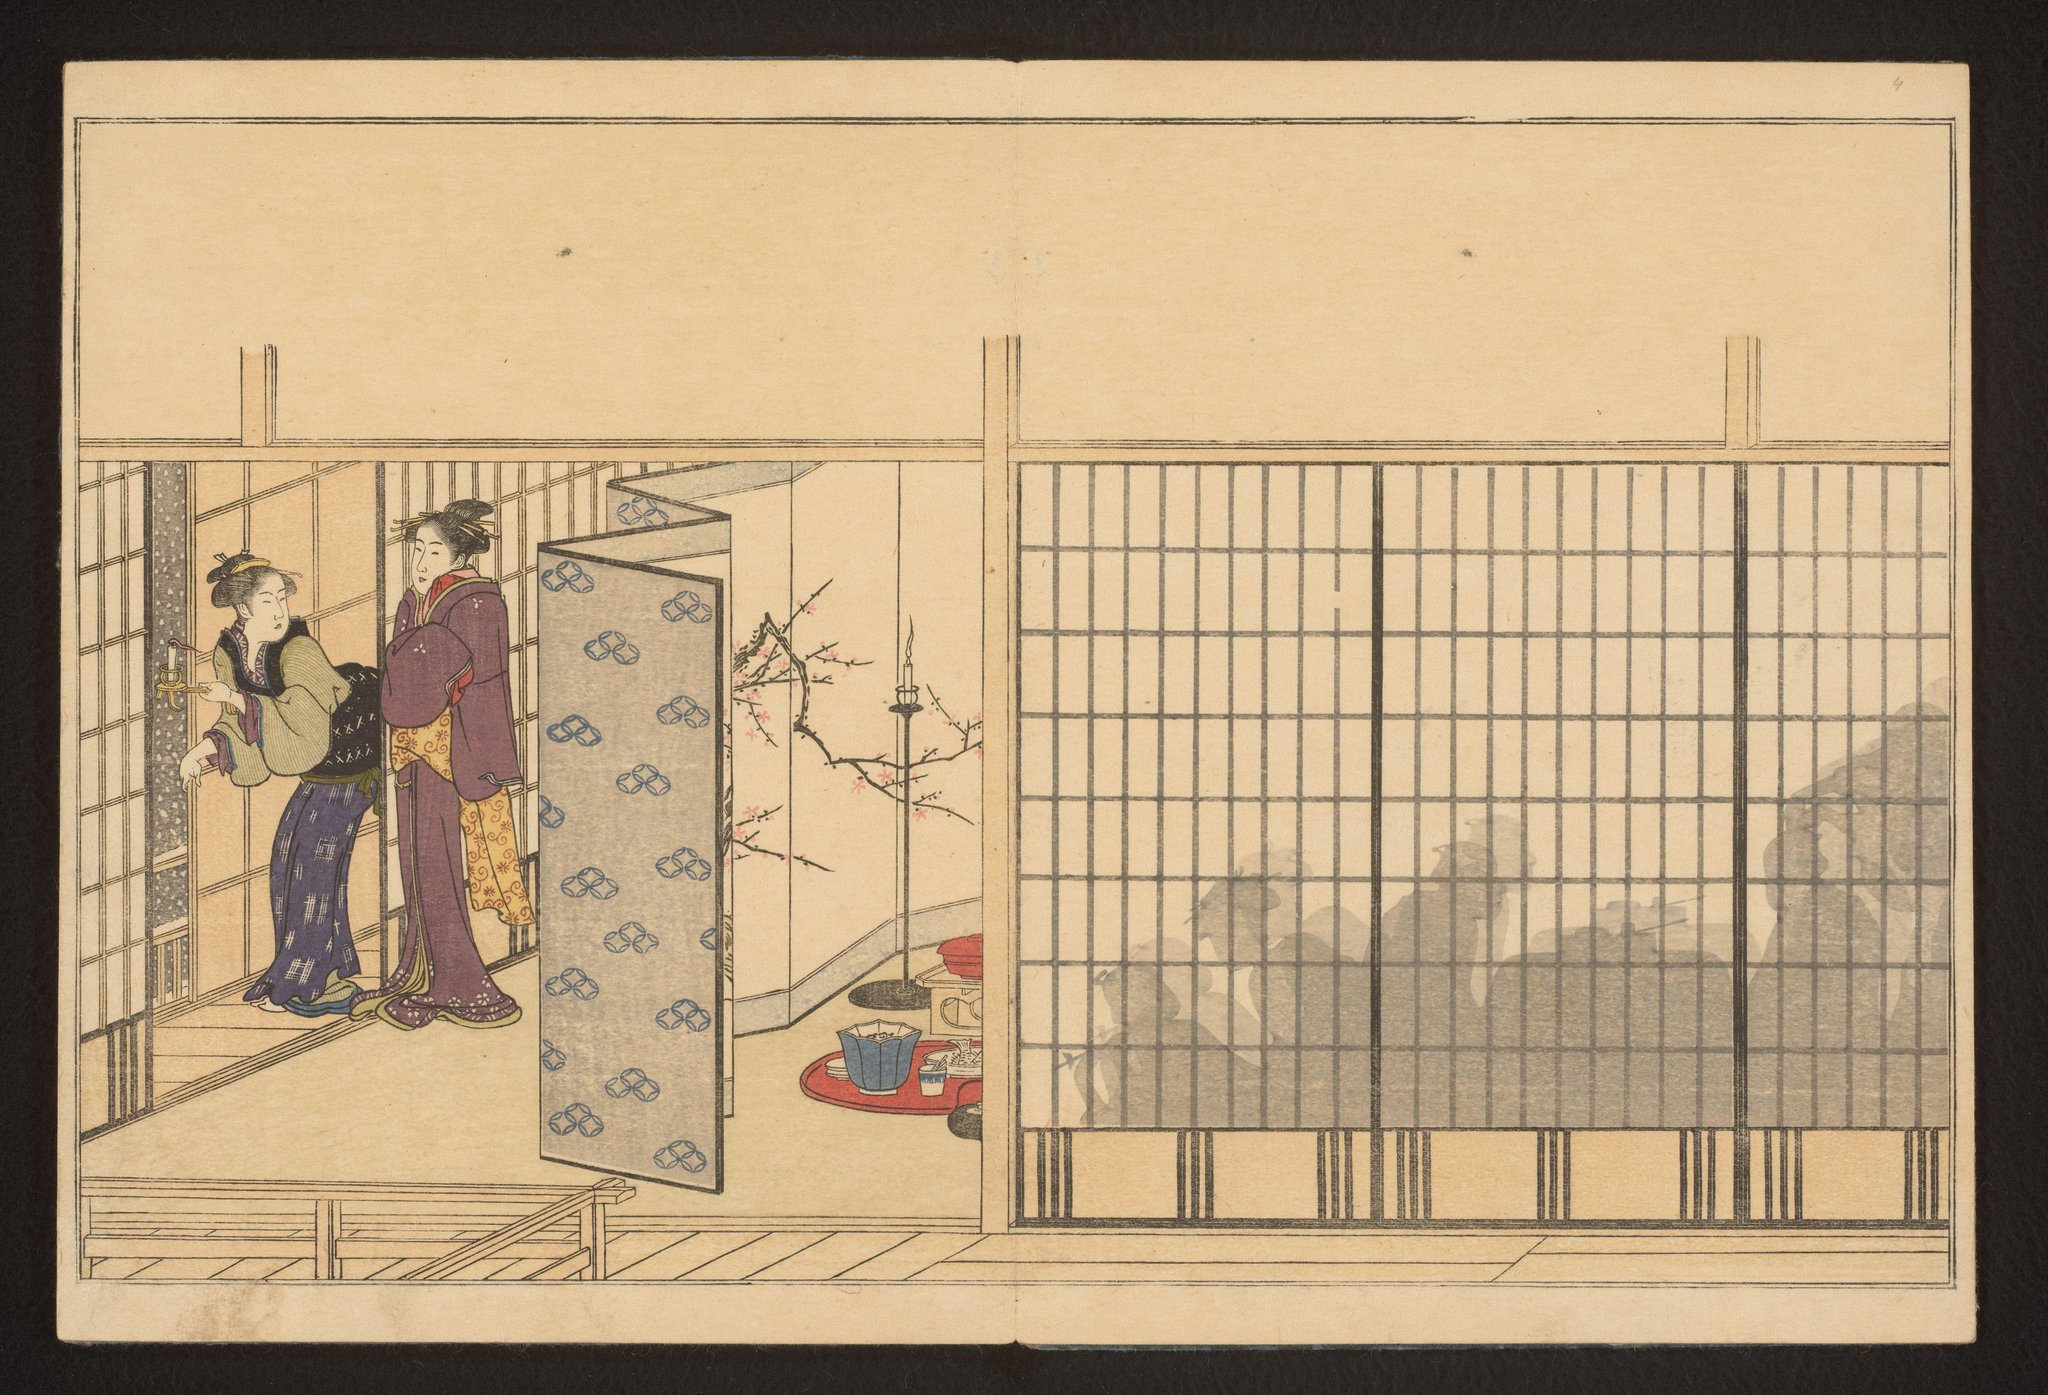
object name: page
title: A party in a house with two women at left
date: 1790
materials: paper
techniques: woodcut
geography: edo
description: Zevende en achtste pagina van het boek Ginsekai van Utamaro.